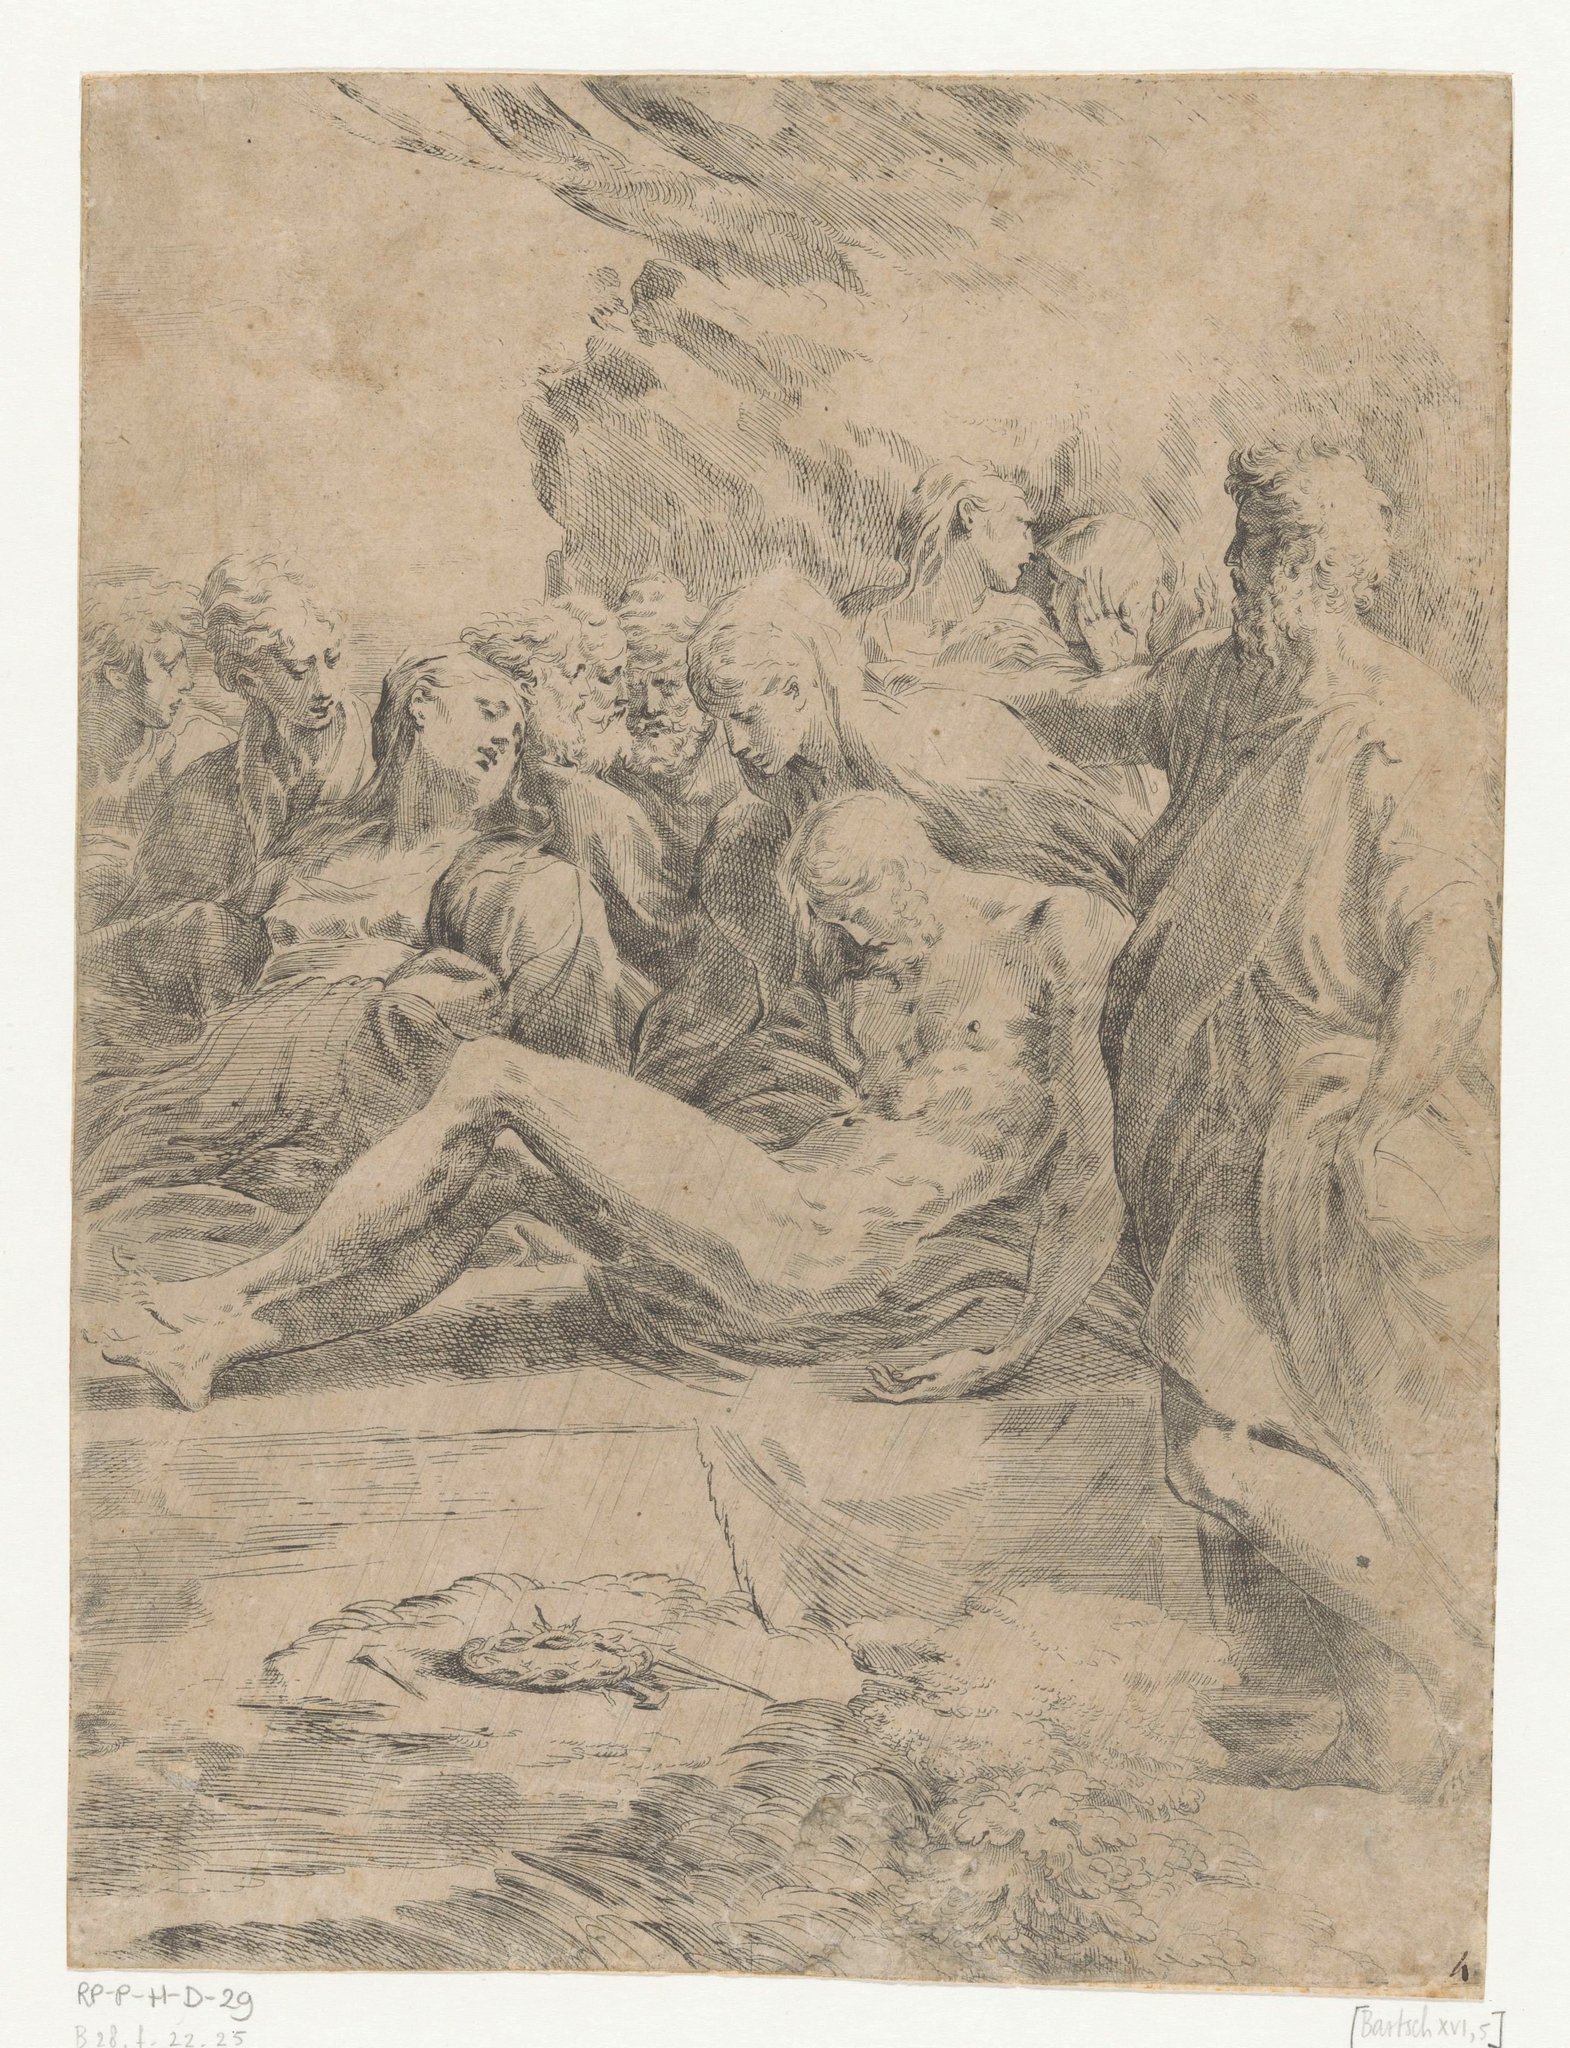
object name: print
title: Graflegging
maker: guido reni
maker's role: draughtsman, painter, print maker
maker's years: 1575-1642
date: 1585-1642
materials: paper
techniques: etching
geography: italy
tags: christ's entombment (possibly by angels)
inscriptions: collector's mark: Lugt 11, collector's mark: Lugt 10, collector's mark: ‘Hinloopen’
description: Het lichaam van Christus is neergelegd op een stenen blok. Rond het lichaam staan treurende mannen en vrouwen.